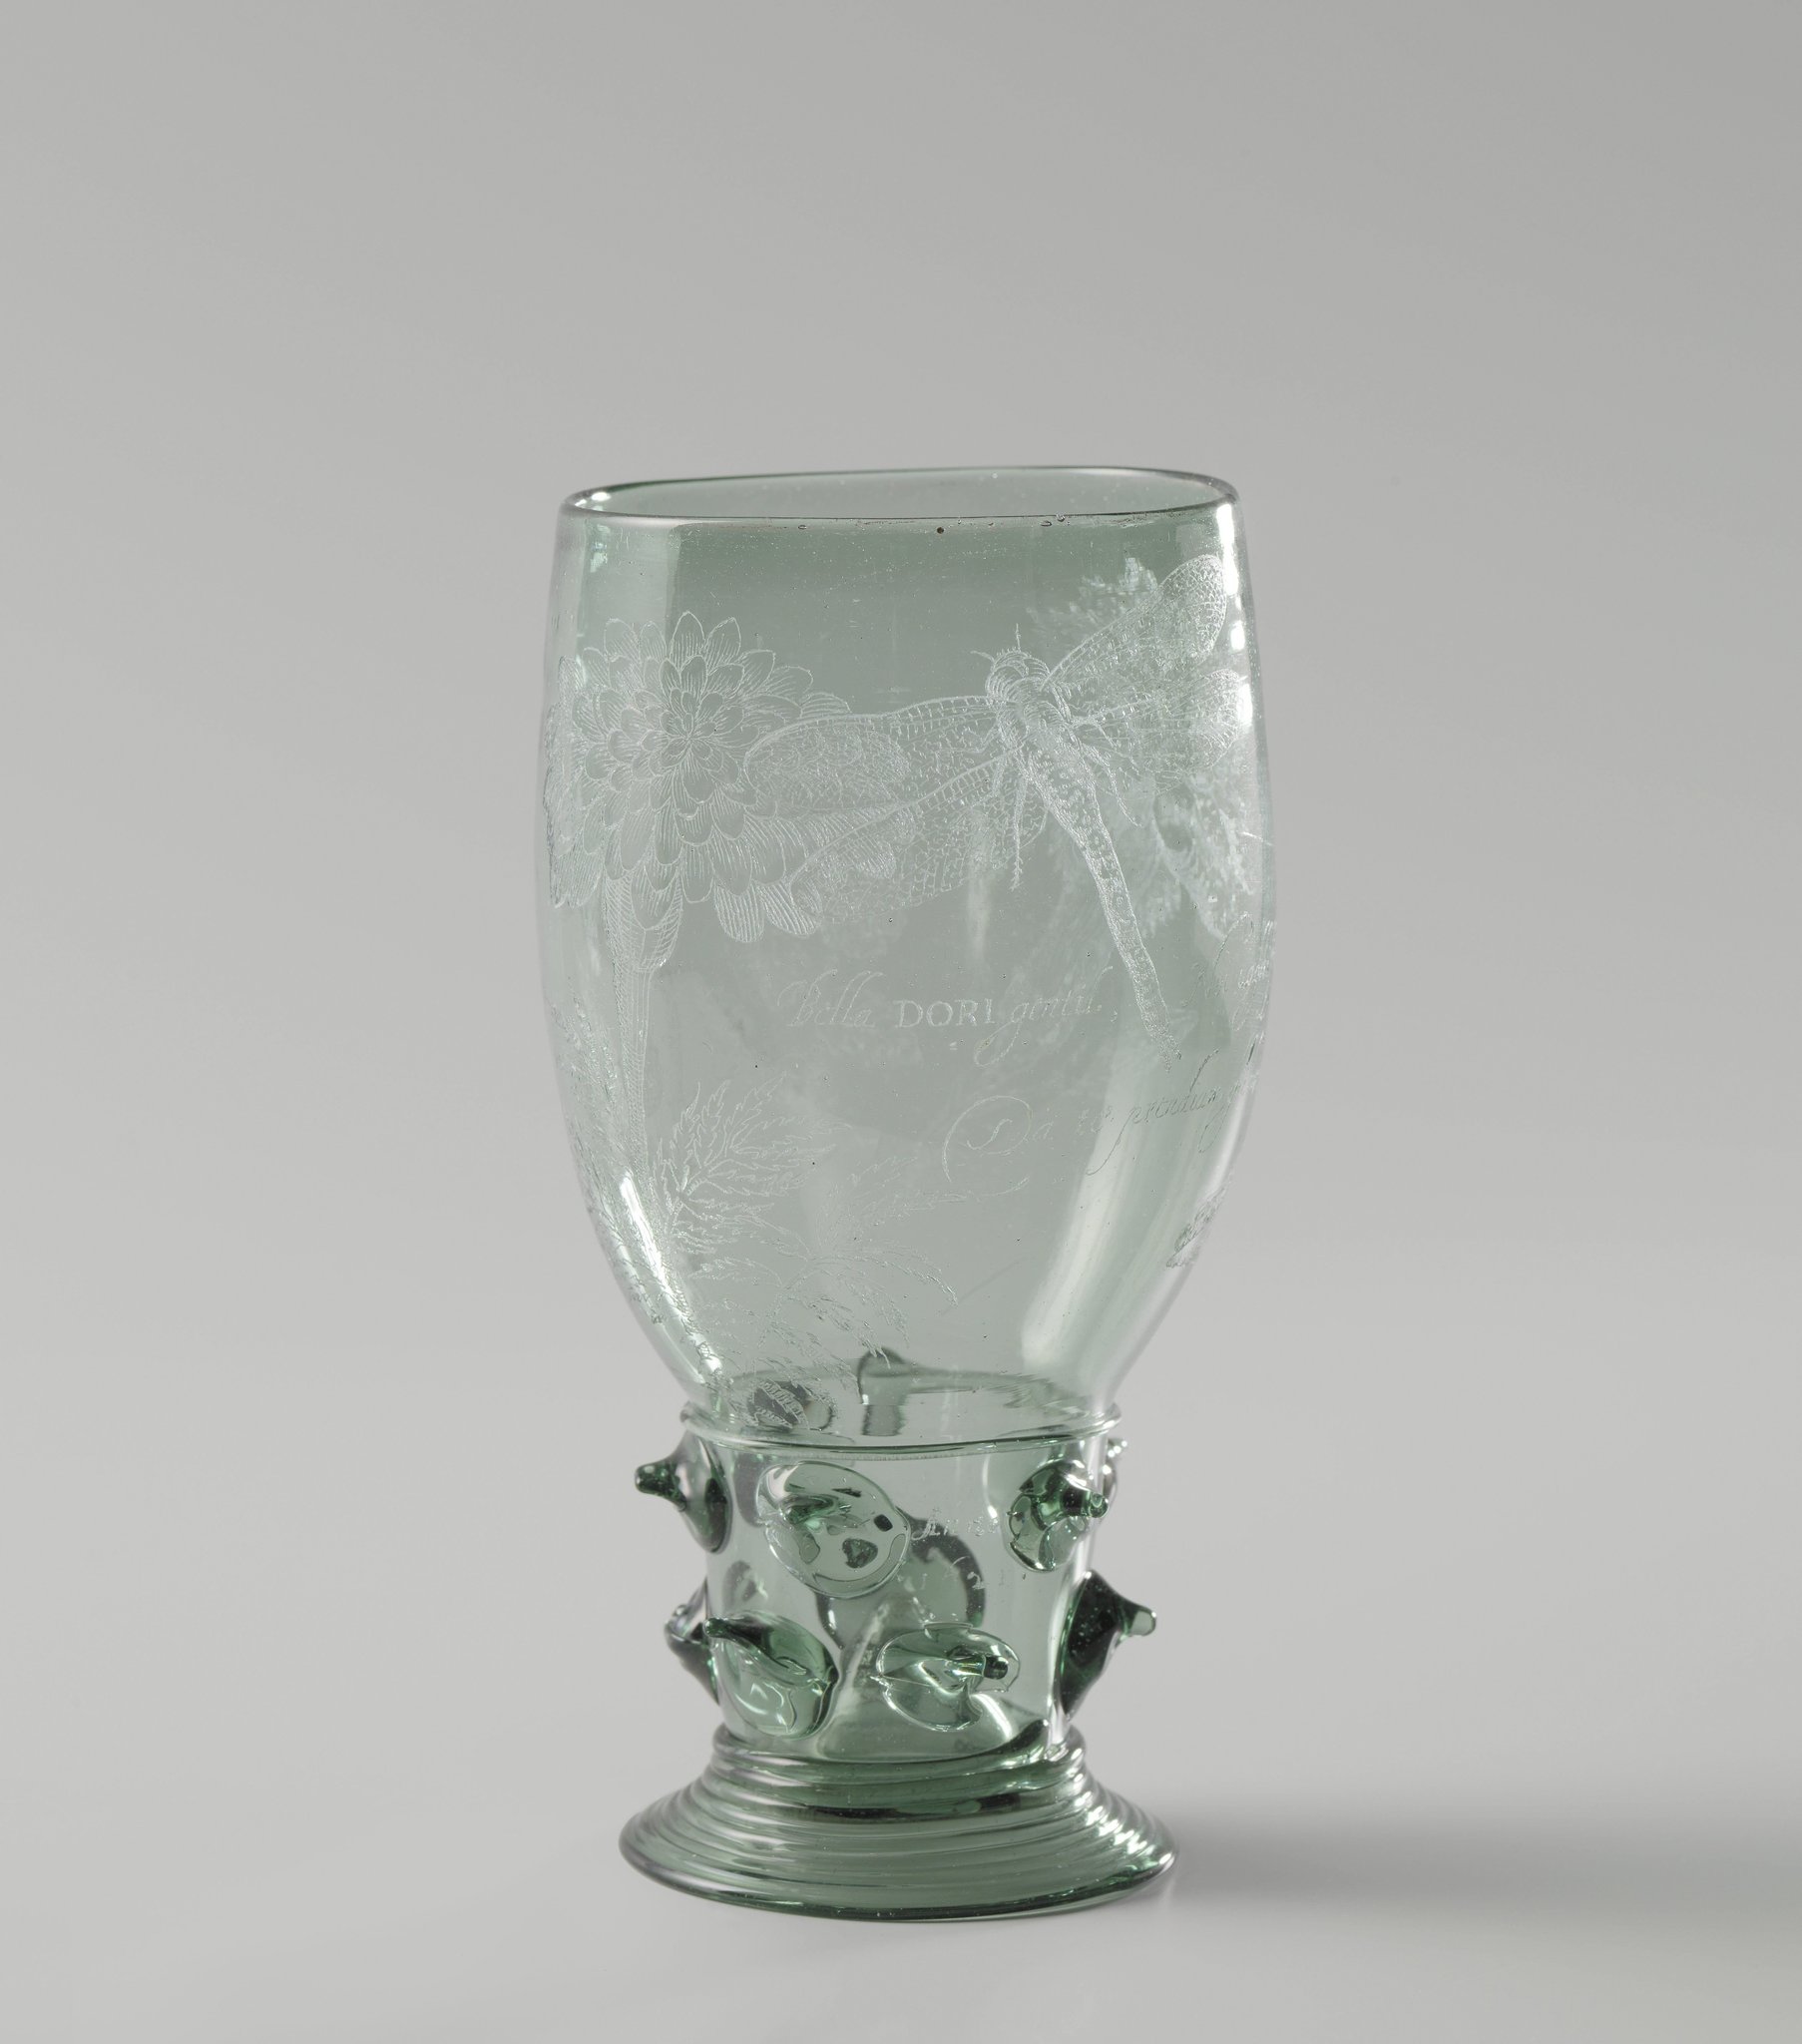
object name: roemer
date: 1621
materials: glass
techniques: diamond point engraving, glassblowing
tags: flowers, insects: dragon-fly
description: Anna Roemers Visscher derived the decorative motifs on this glass – such as the flowers and the dragonfly – from old prints. In the cryptic Italian inscription, the flowers address a certain Dora or Dorothea, whom they thank for bestowing fame on them.